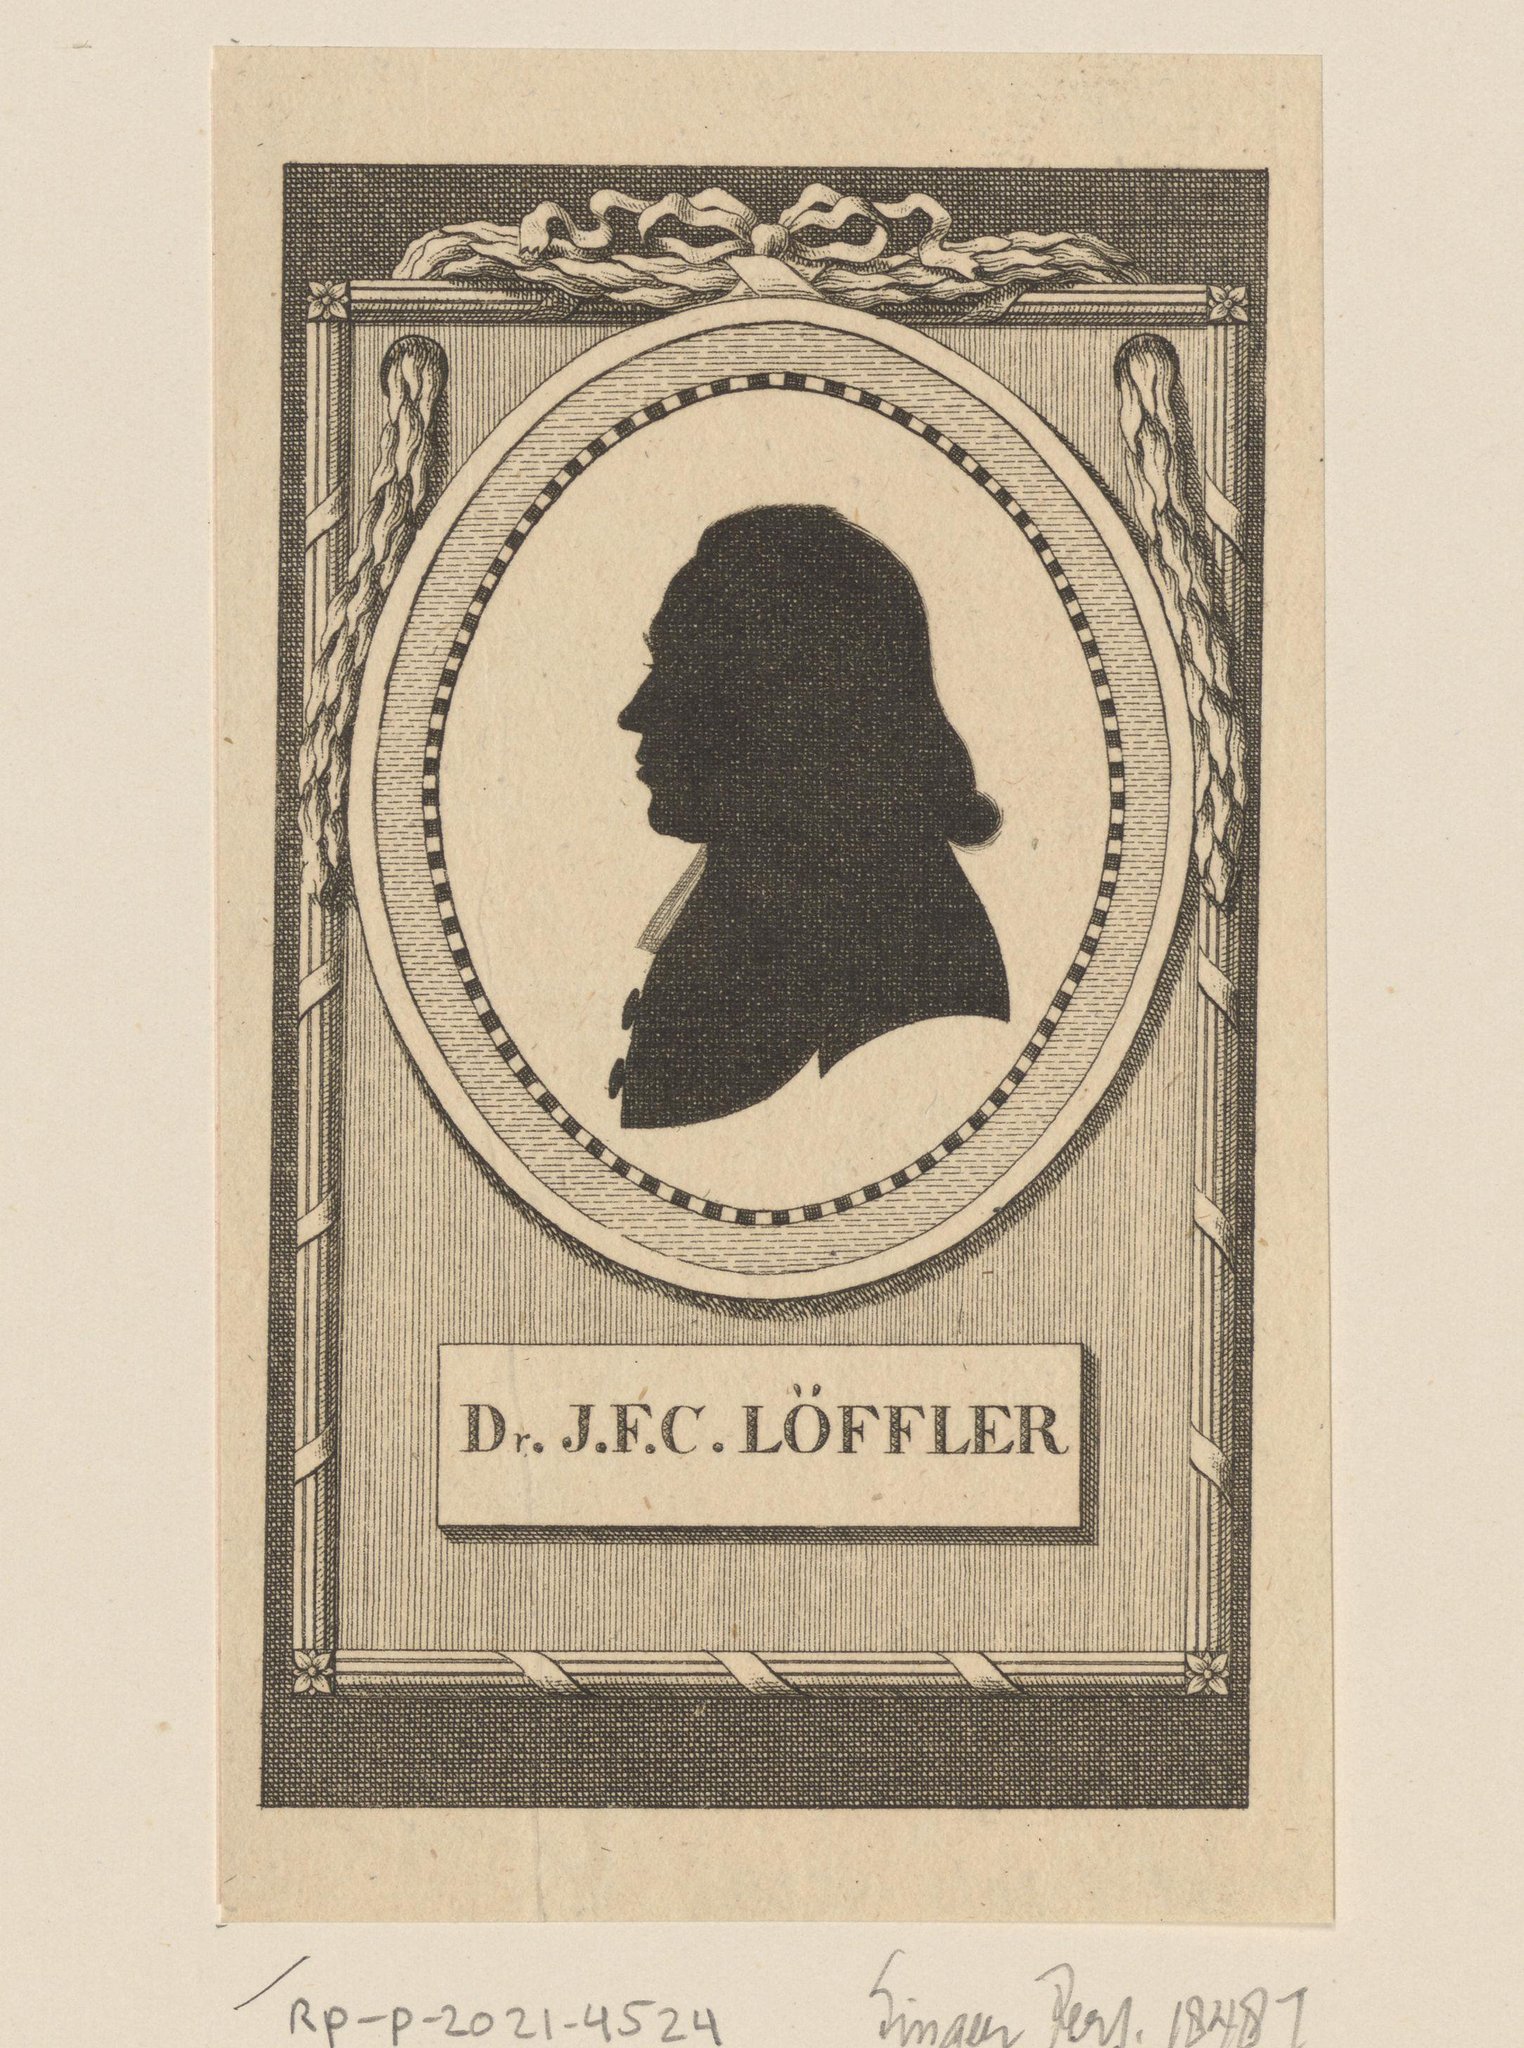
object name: print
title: Silhouetportret van Josias Friedrich Christian Löffler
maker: Anonymous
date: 1780-1850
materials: paper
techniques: etching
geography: germany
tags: ornament ~ medallion, historical persons